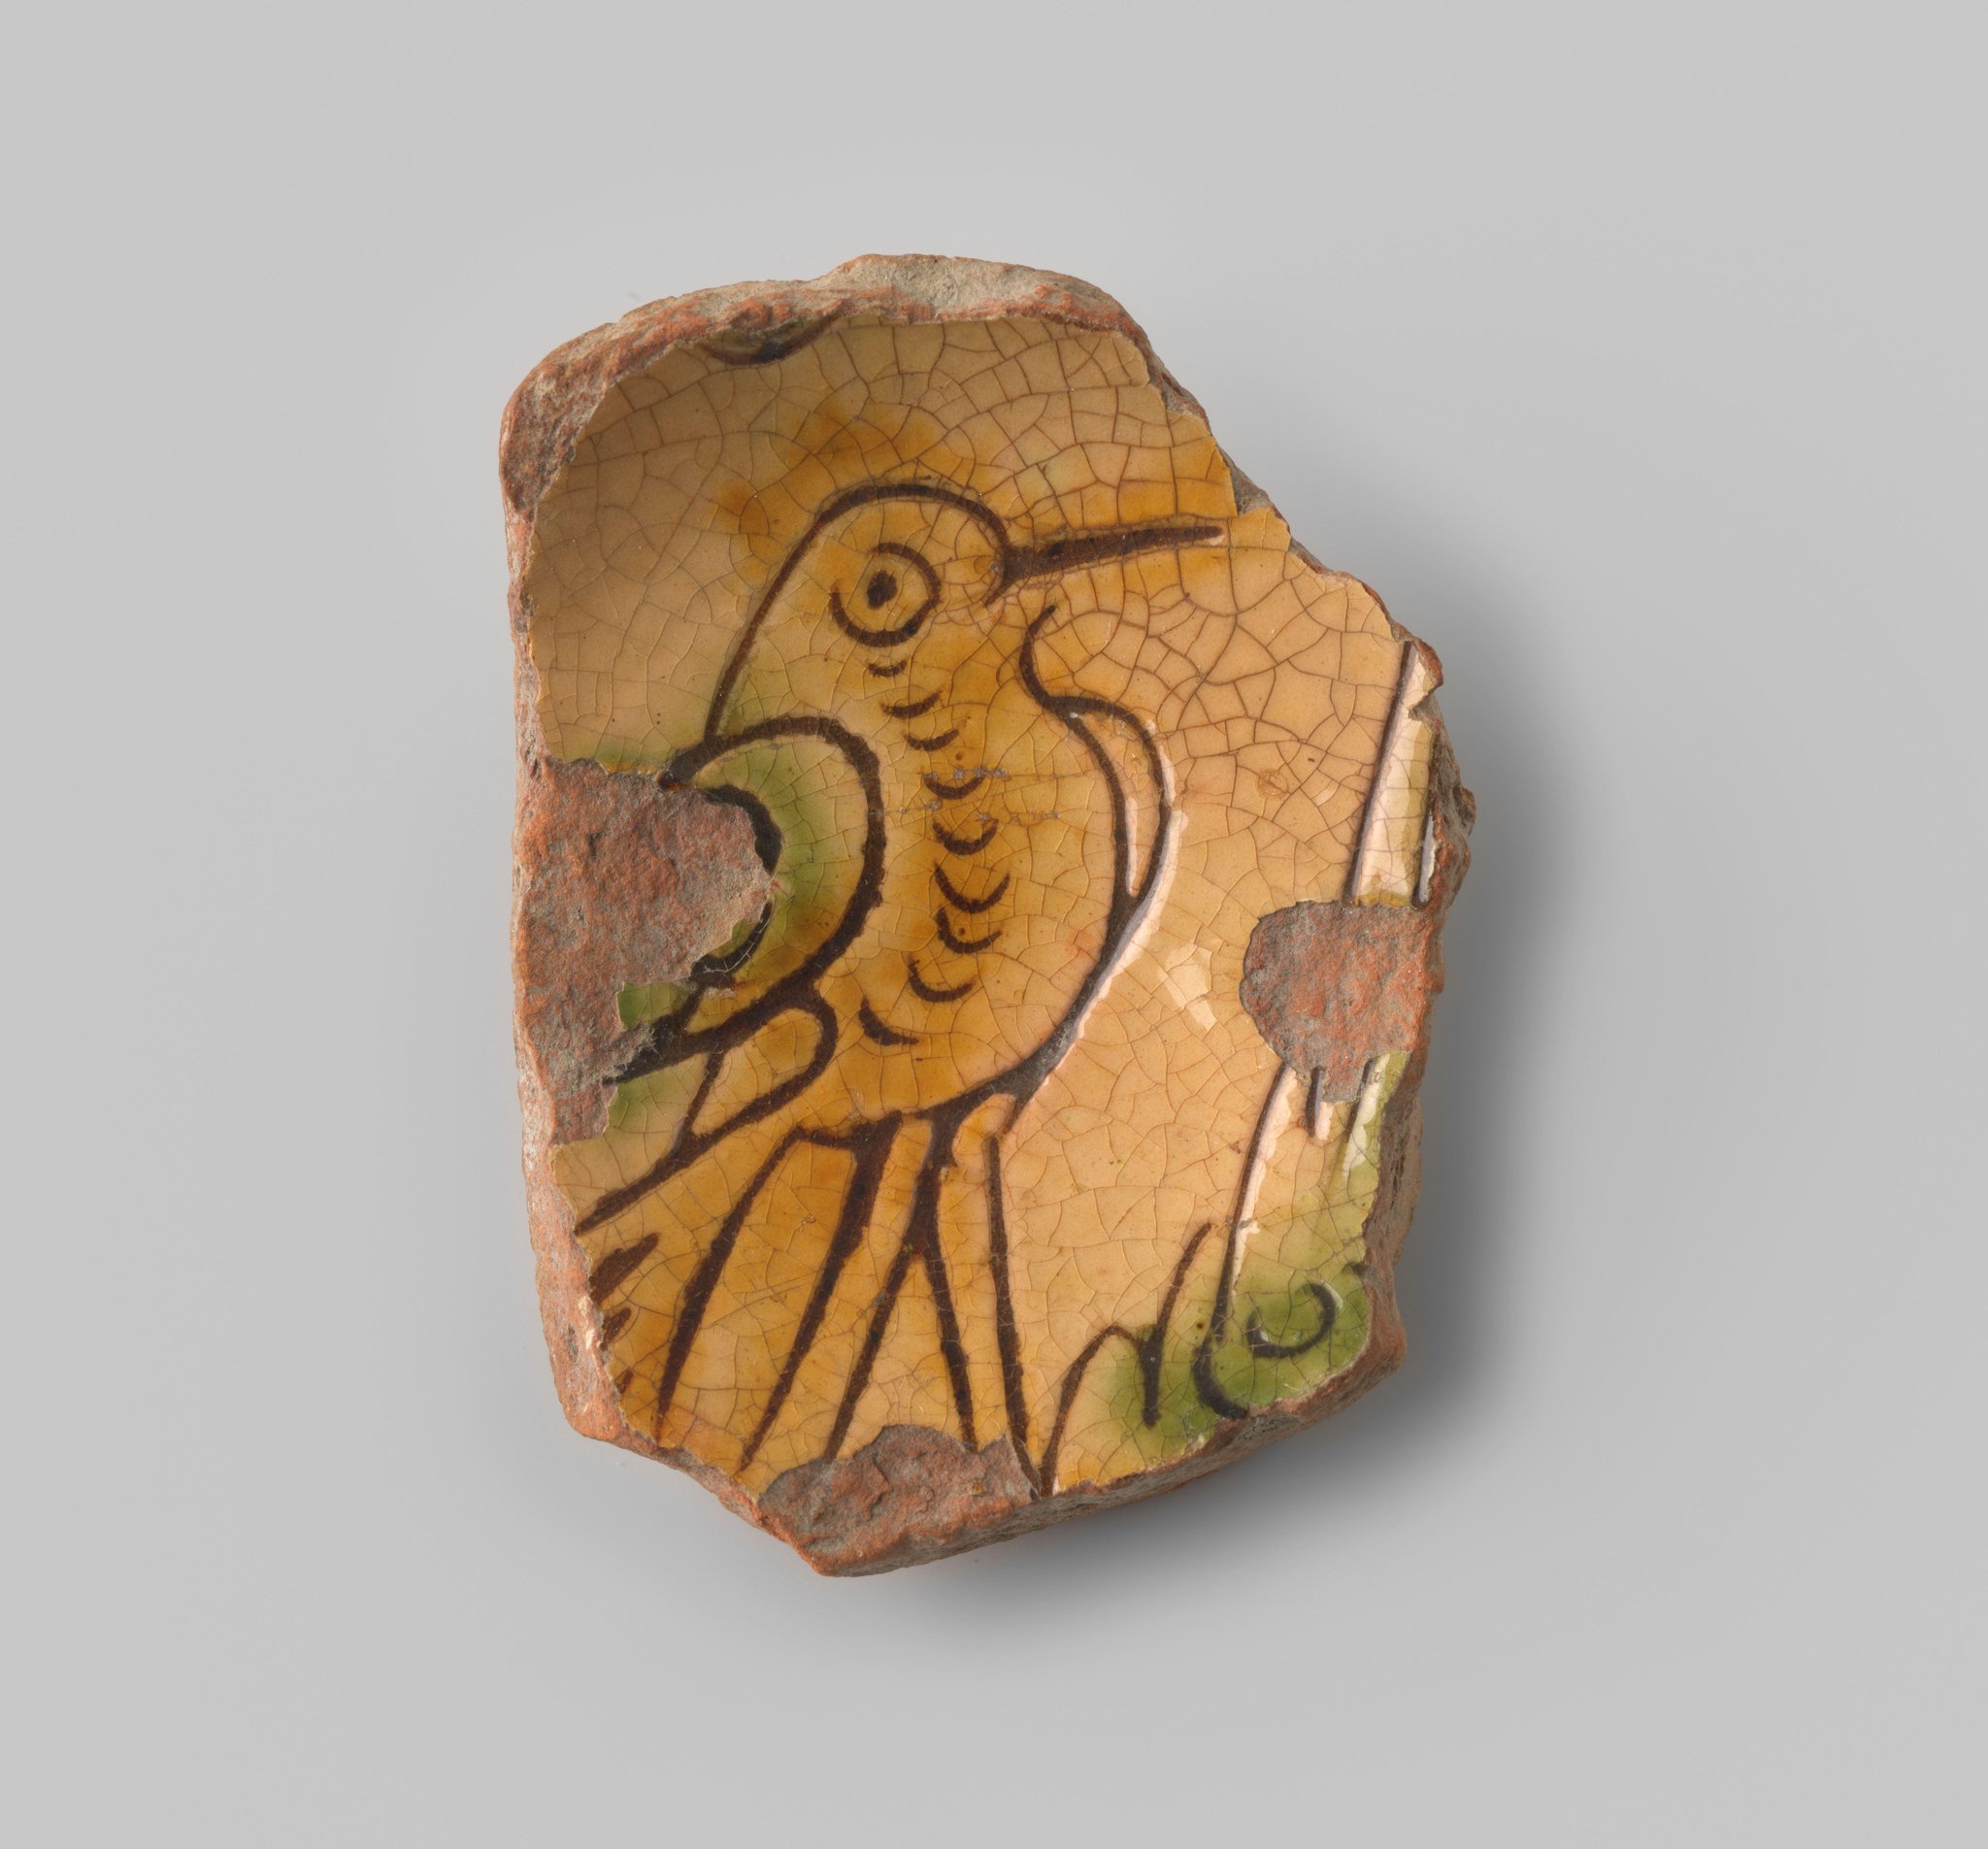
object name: sherd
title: Fragment (voet) met rode scherf, aan de binnenkant in sgraffito-techniek een vogel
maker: Anonymous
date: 1200-1899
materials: earthenware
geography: italy